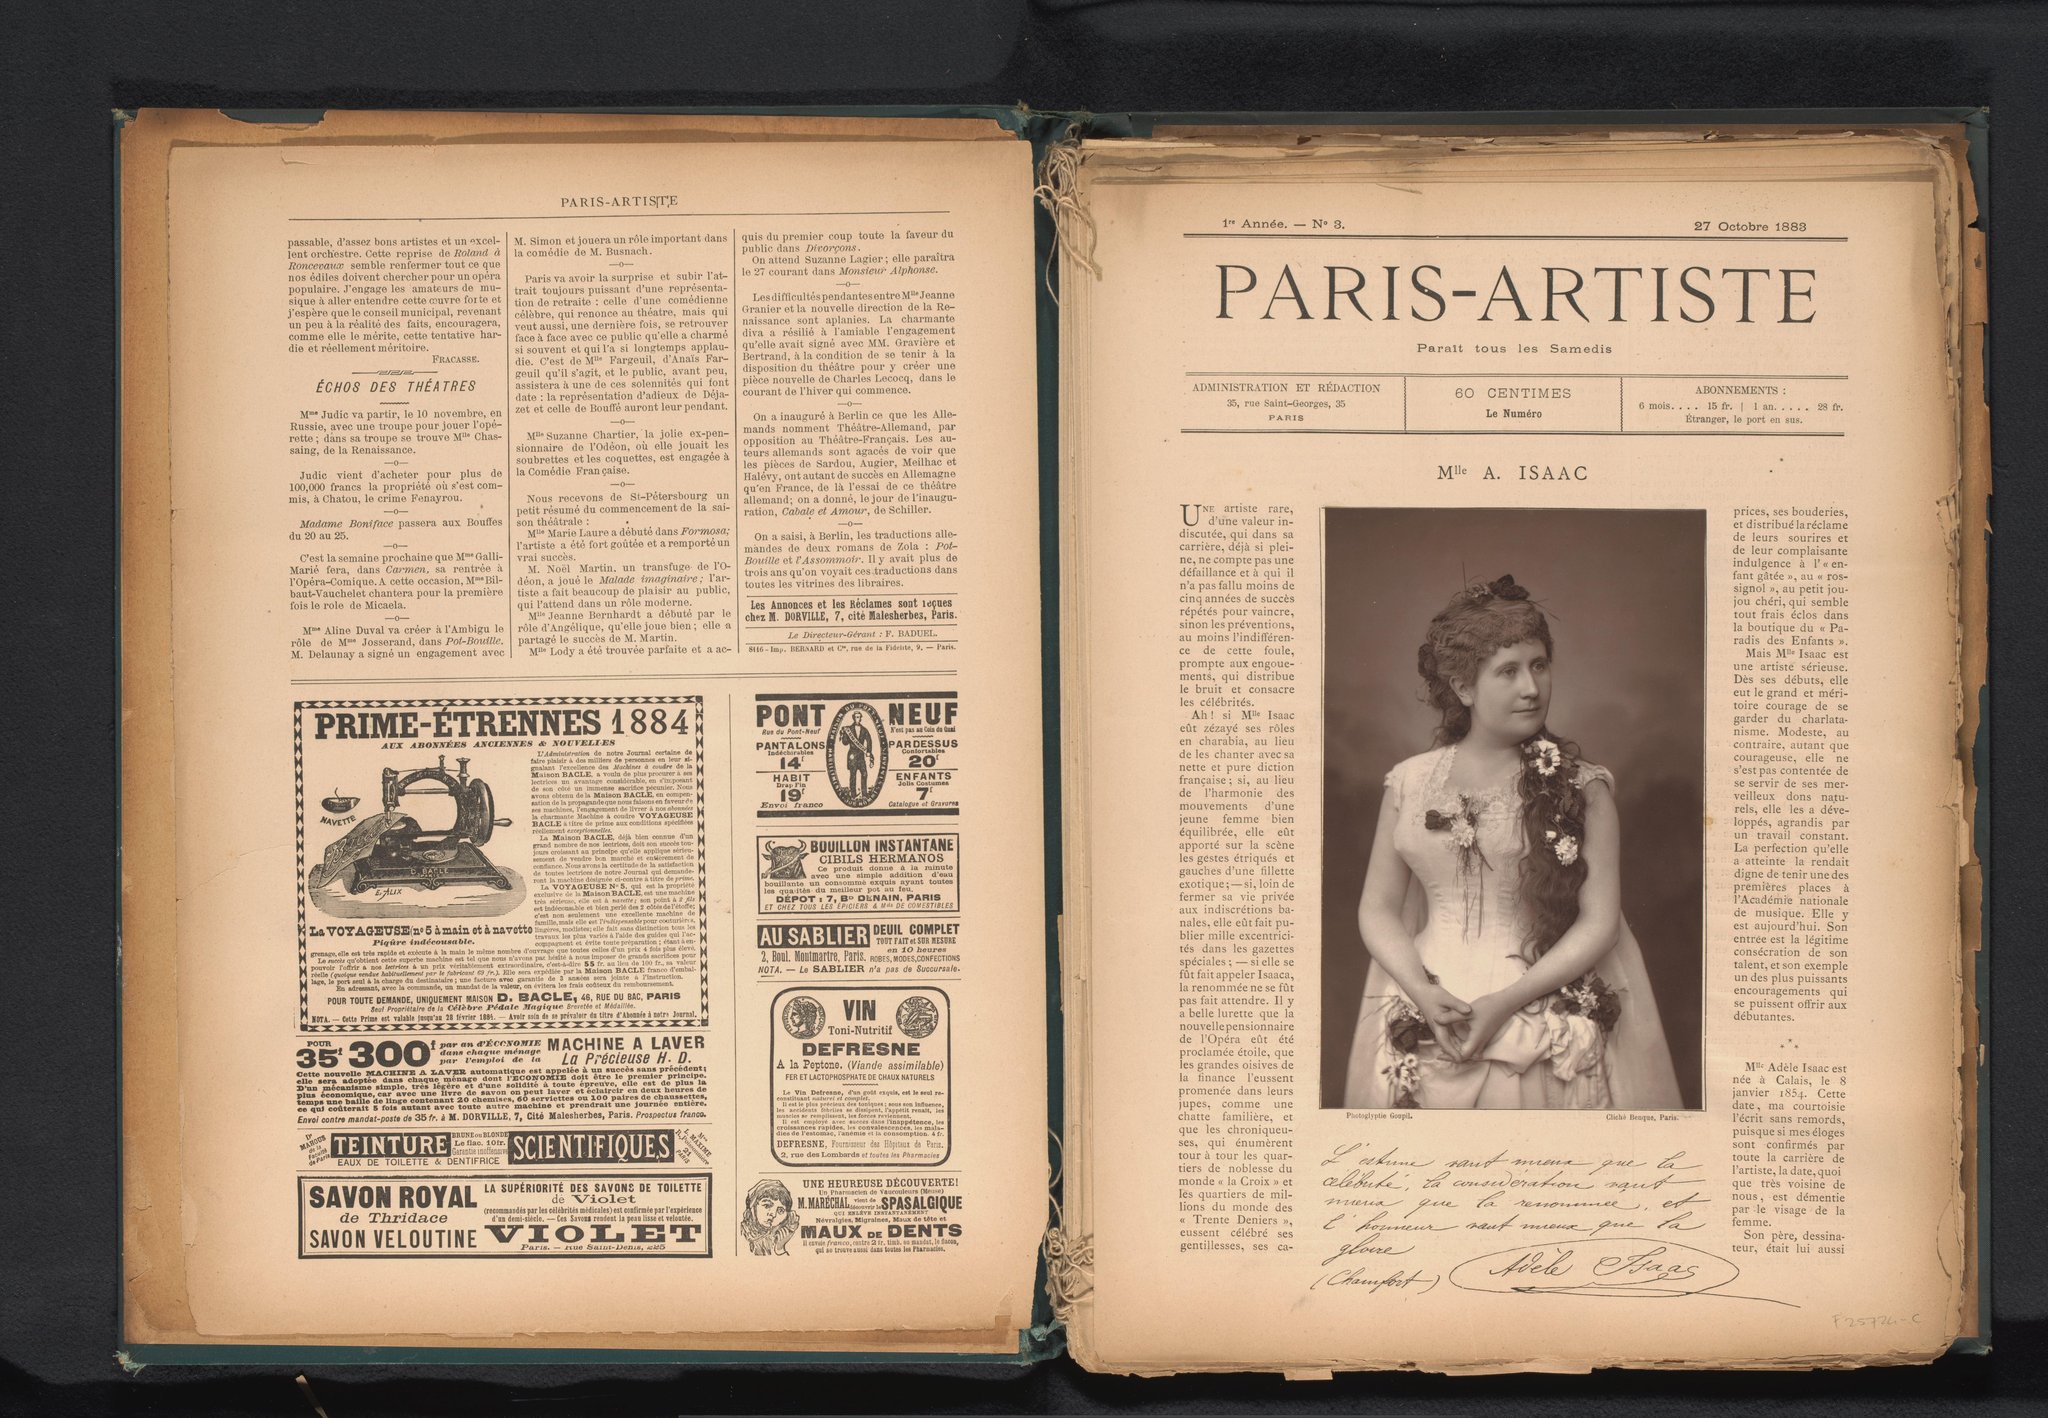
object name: photomechanical print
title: Portret van Adèle Isaac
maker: wilhelm benque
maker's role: fotograaf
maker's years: 1843-1903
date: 1878-1883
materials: paper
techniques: woodburytype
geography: paris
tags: paris, historical persons - bb - woman, portrait of opera-singer